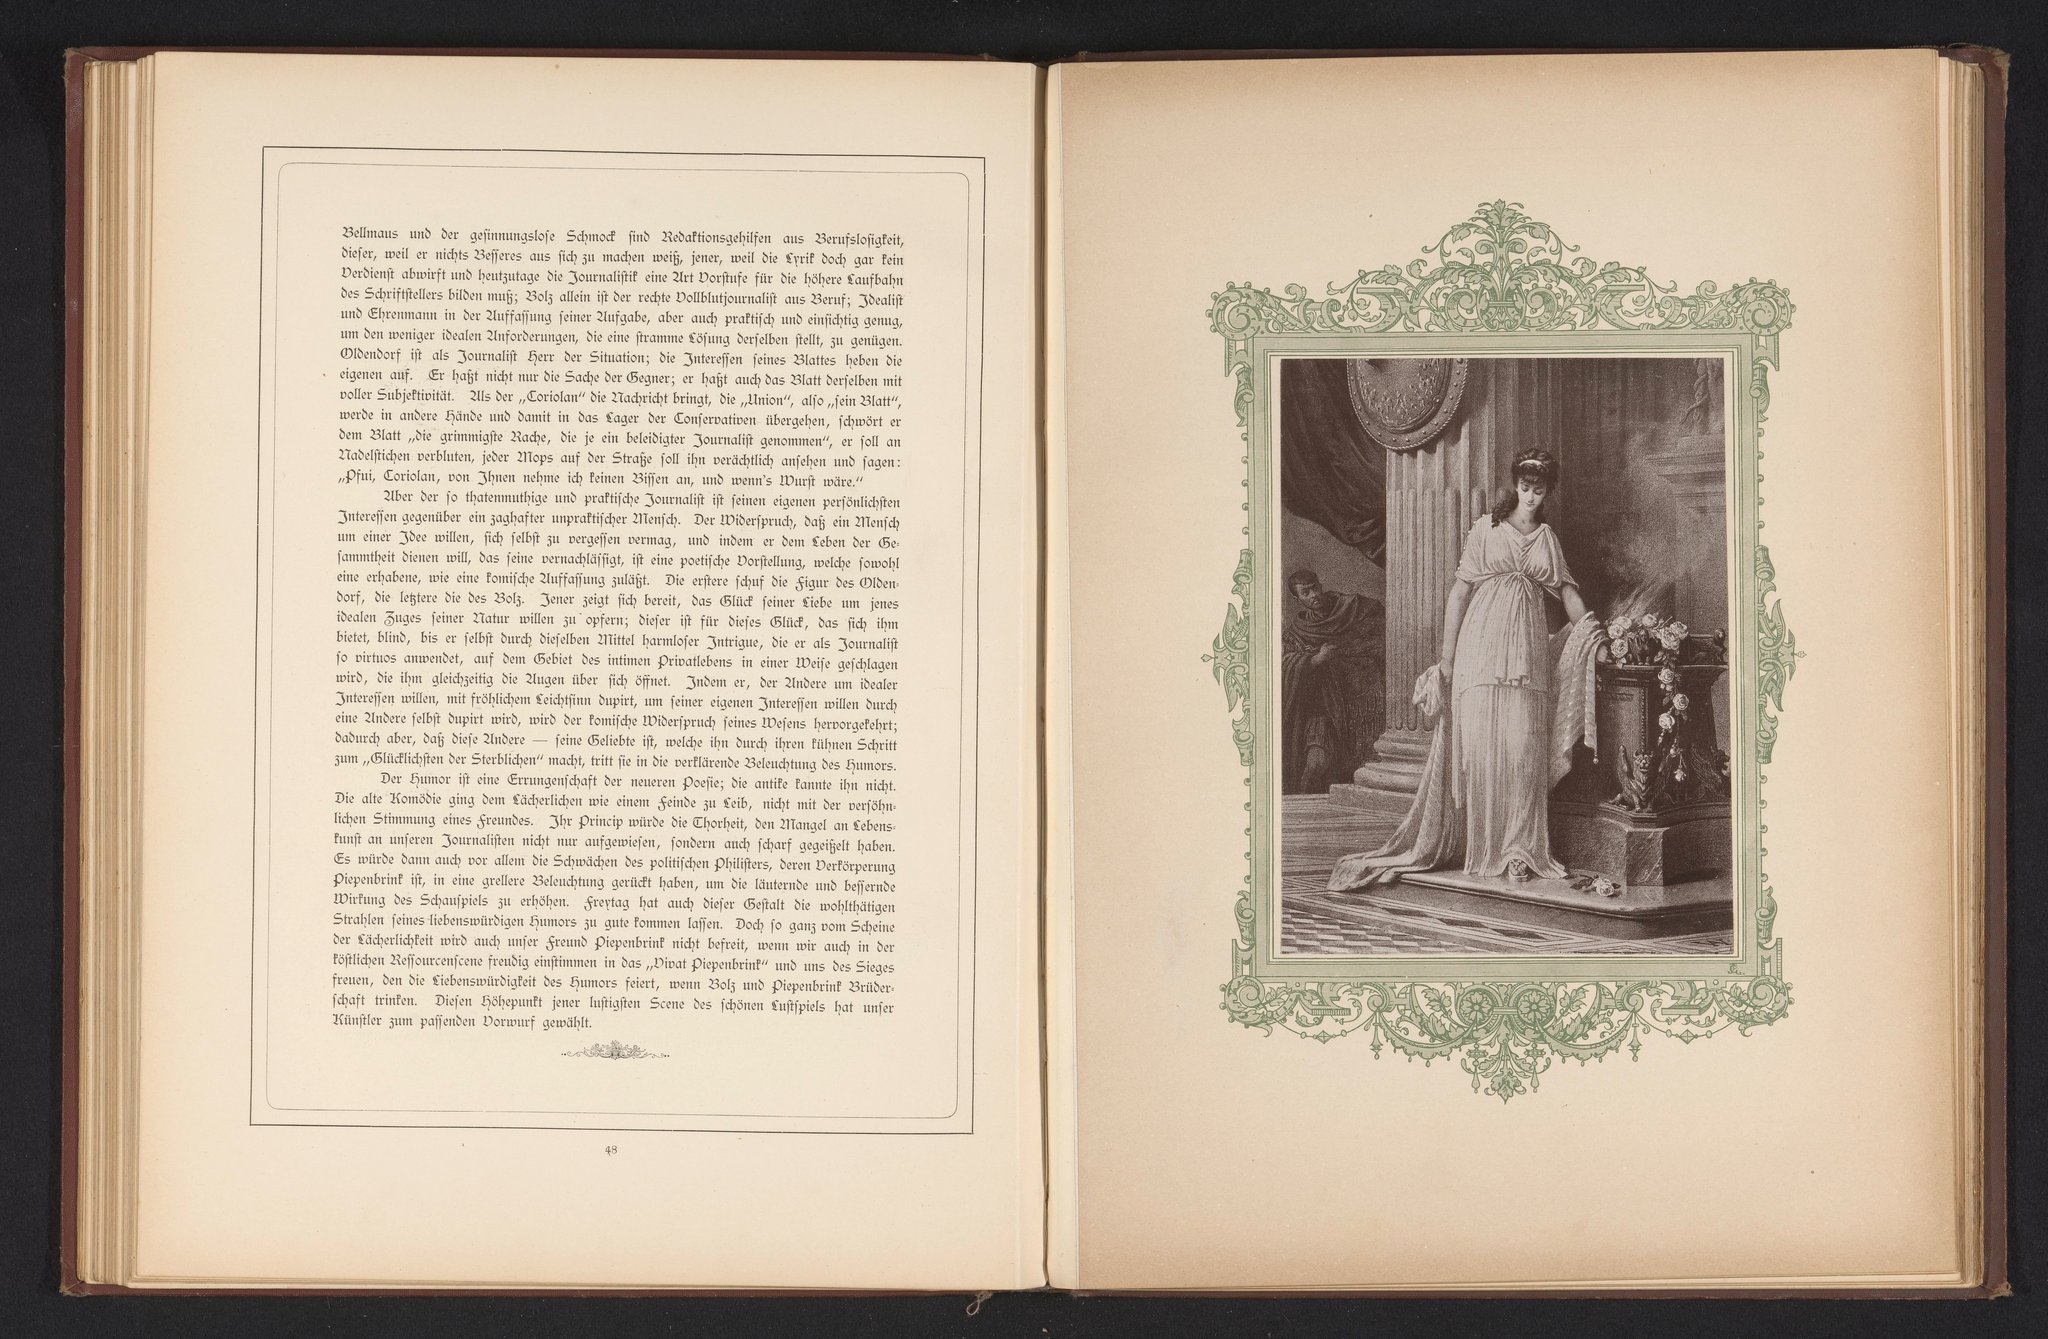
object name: reproduction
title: Fotoreproductie van een schilderij voorstellende Fabia en Icilius uit Soll und Haben door Gustav Freytag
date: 1877-1882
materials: paper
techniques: photograph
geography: germany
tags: adult woman, column, pillar ~ architecture, altar